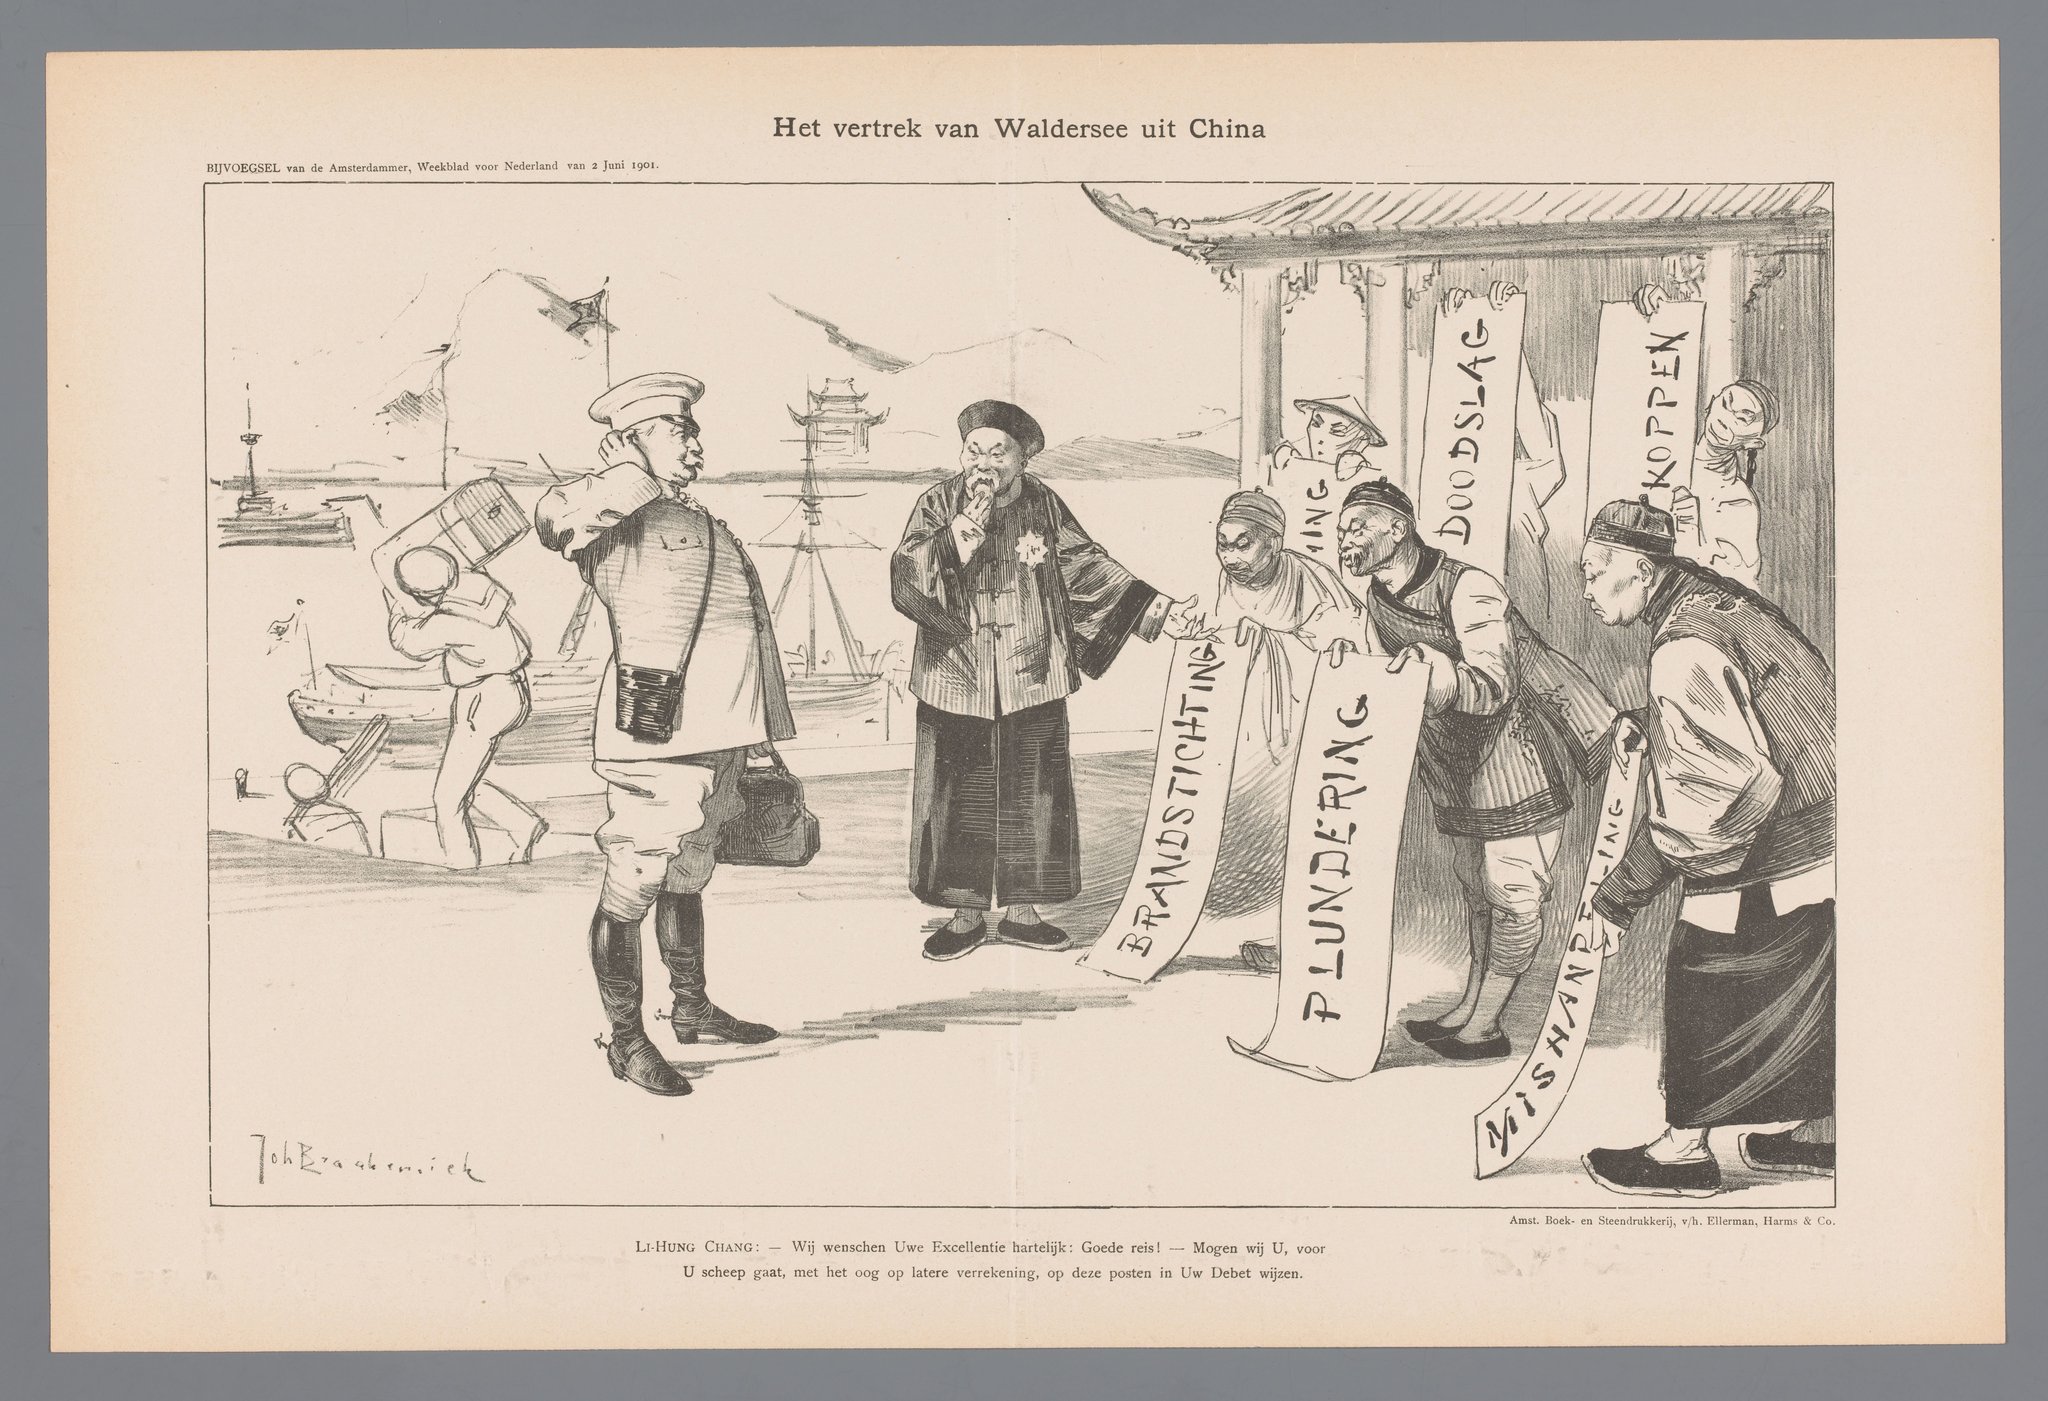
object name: cartoon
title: Het vertrek van Waldersee uit China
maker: johan braakensiek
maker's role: draughtsman, print maker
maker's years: 1858-1940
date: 1901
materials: paper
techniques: lithograph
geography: amsterdam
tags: china, politician, historical persons, political caricatures and satires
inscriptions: date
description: Prent uit het bijvoegsel van: De Amsterdammer. Weekblad voor Nederland, 2 juni 1901.